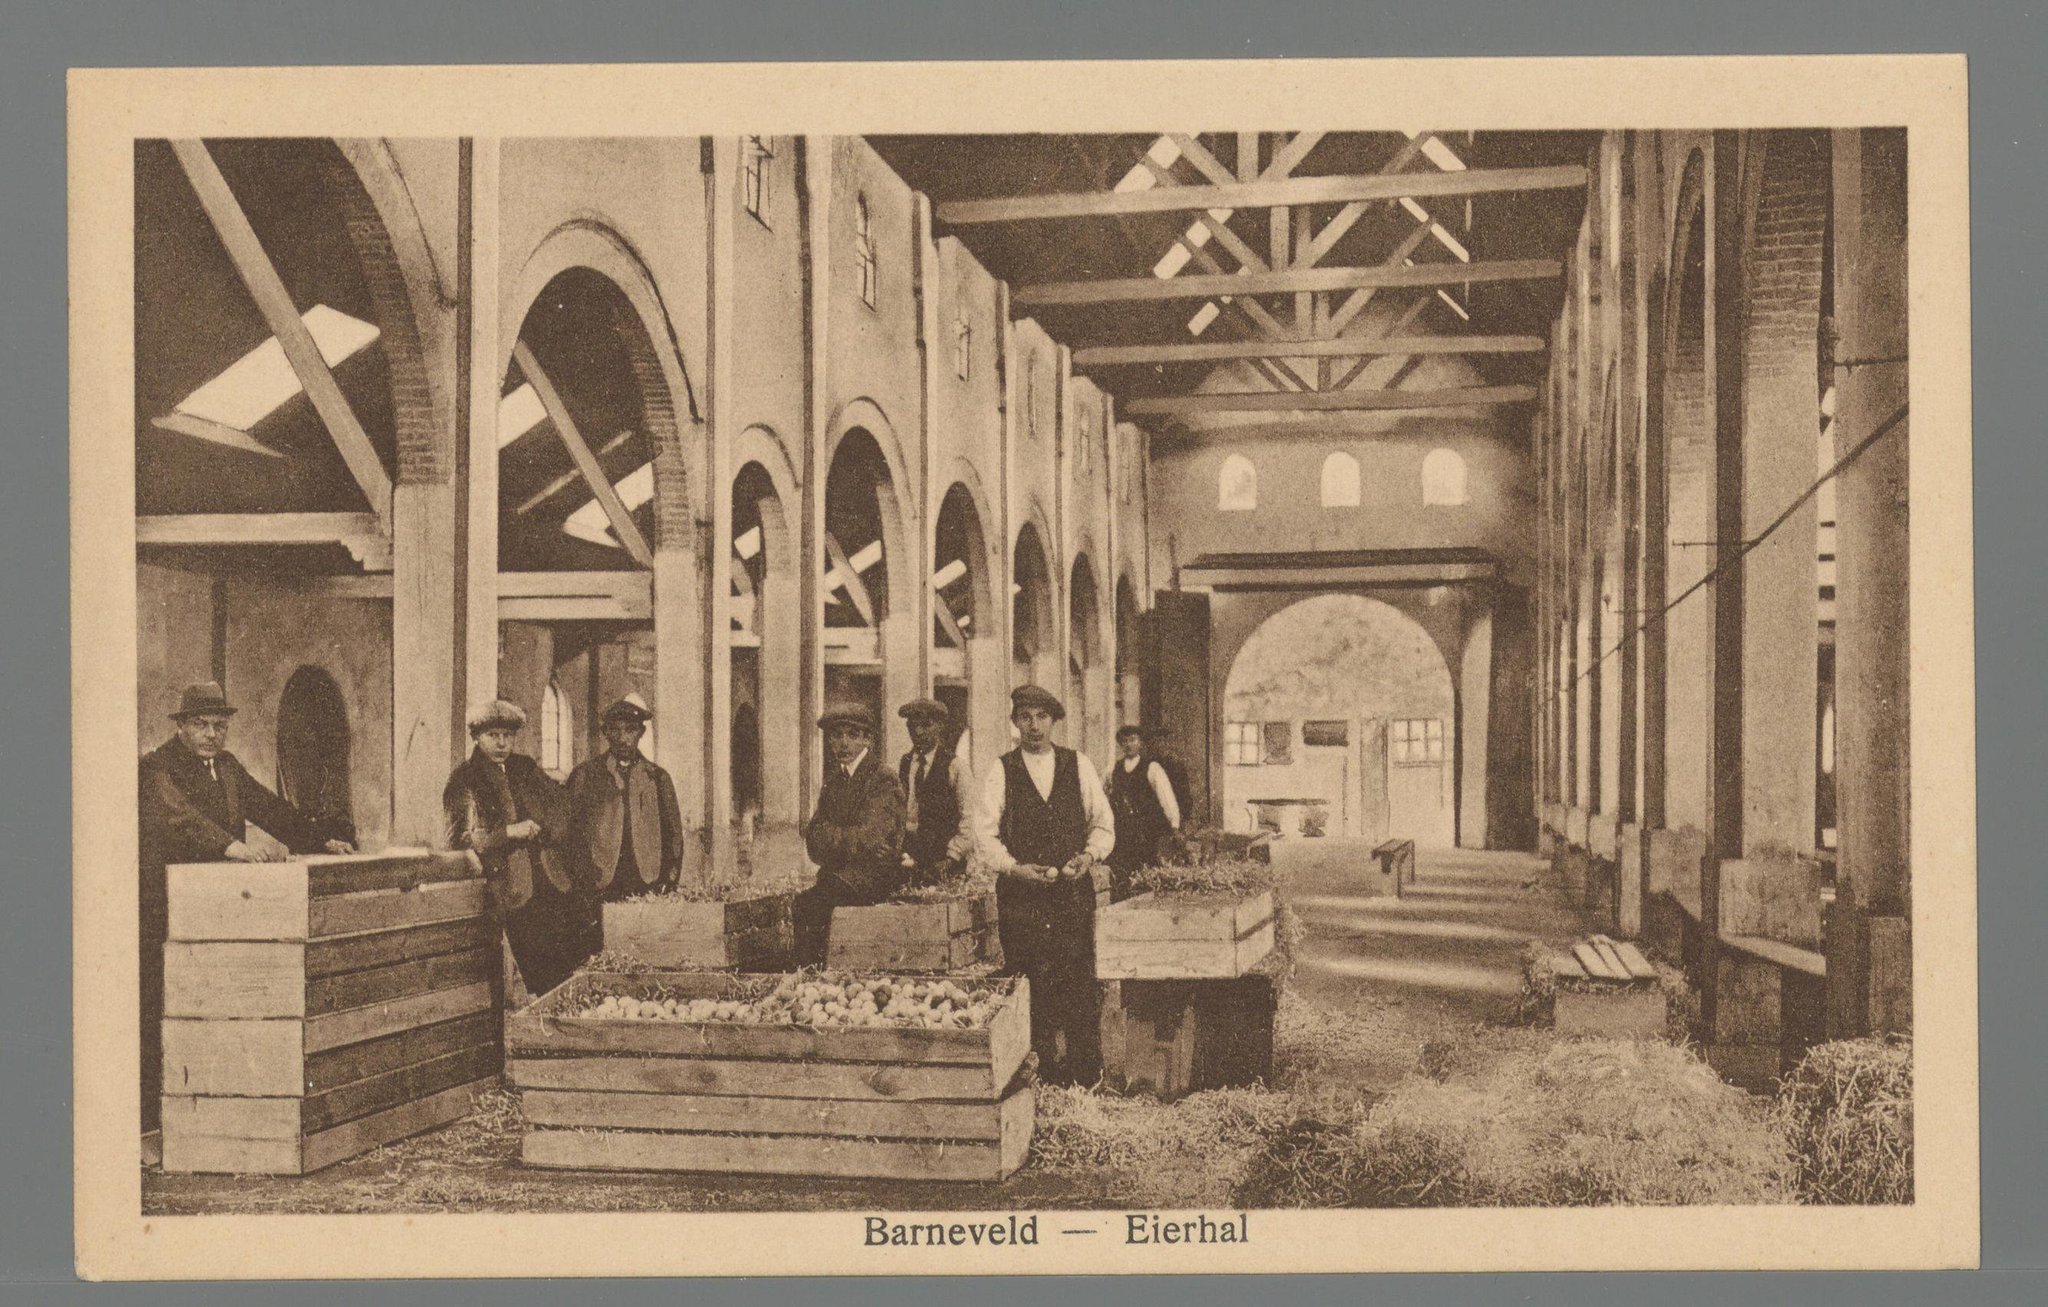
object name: ansichtkaart, prentbriefkaart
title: Barneveld - eierhal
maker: Anonymous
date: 1913-1930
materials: cardboard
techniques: photograph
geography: barneveld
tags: eggs, egg-dishes